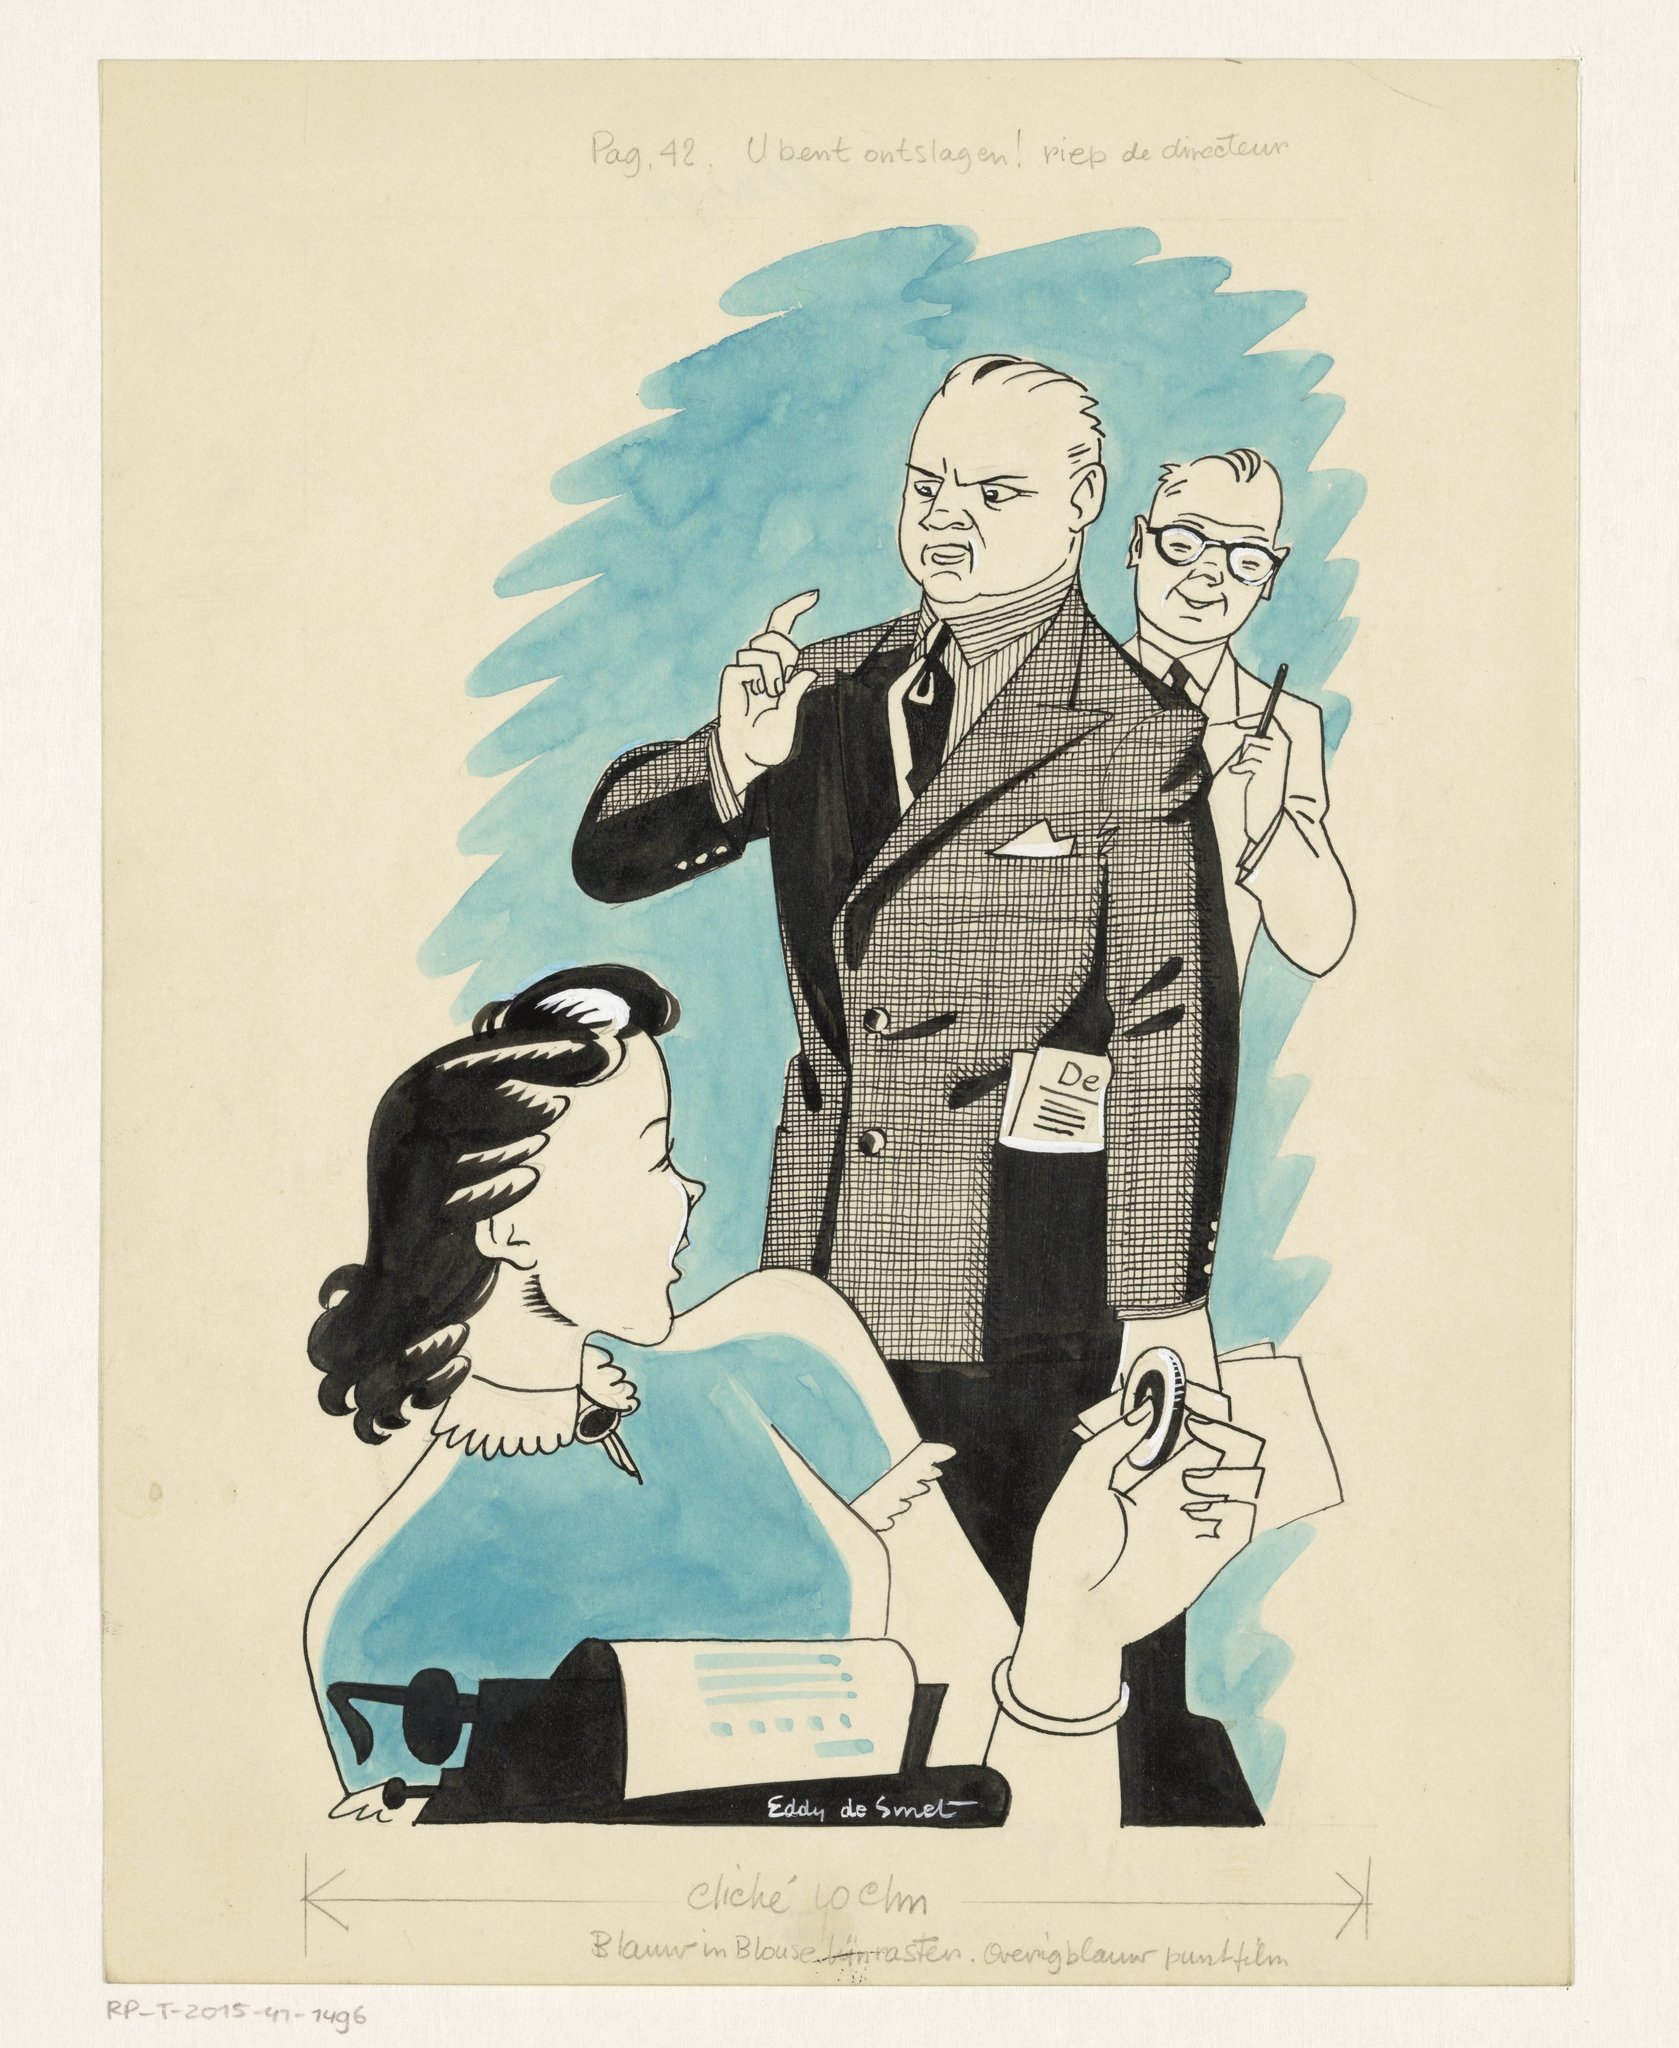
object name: drawing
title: Marjo wordt ontslagen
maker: eddy de smet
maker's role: draughtsman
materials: paint, ink, paper, pencil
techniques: brush, pen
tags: director, boss (in modern industry), typewriter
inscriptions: :, signature: ‘Eddy de Smet’, collector's mark: Lugt 2228, annotation: ‘Pag. 42. U bent ontslagen! riep de directeur’, annotation: ‘Marjo’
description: Marjo zit achter een schrijfmachine. Ze heeft een rond voorwerp in haar hand en draait zich om. Achter haar staat de directeur die vermanend zijn vinger opsteekt.